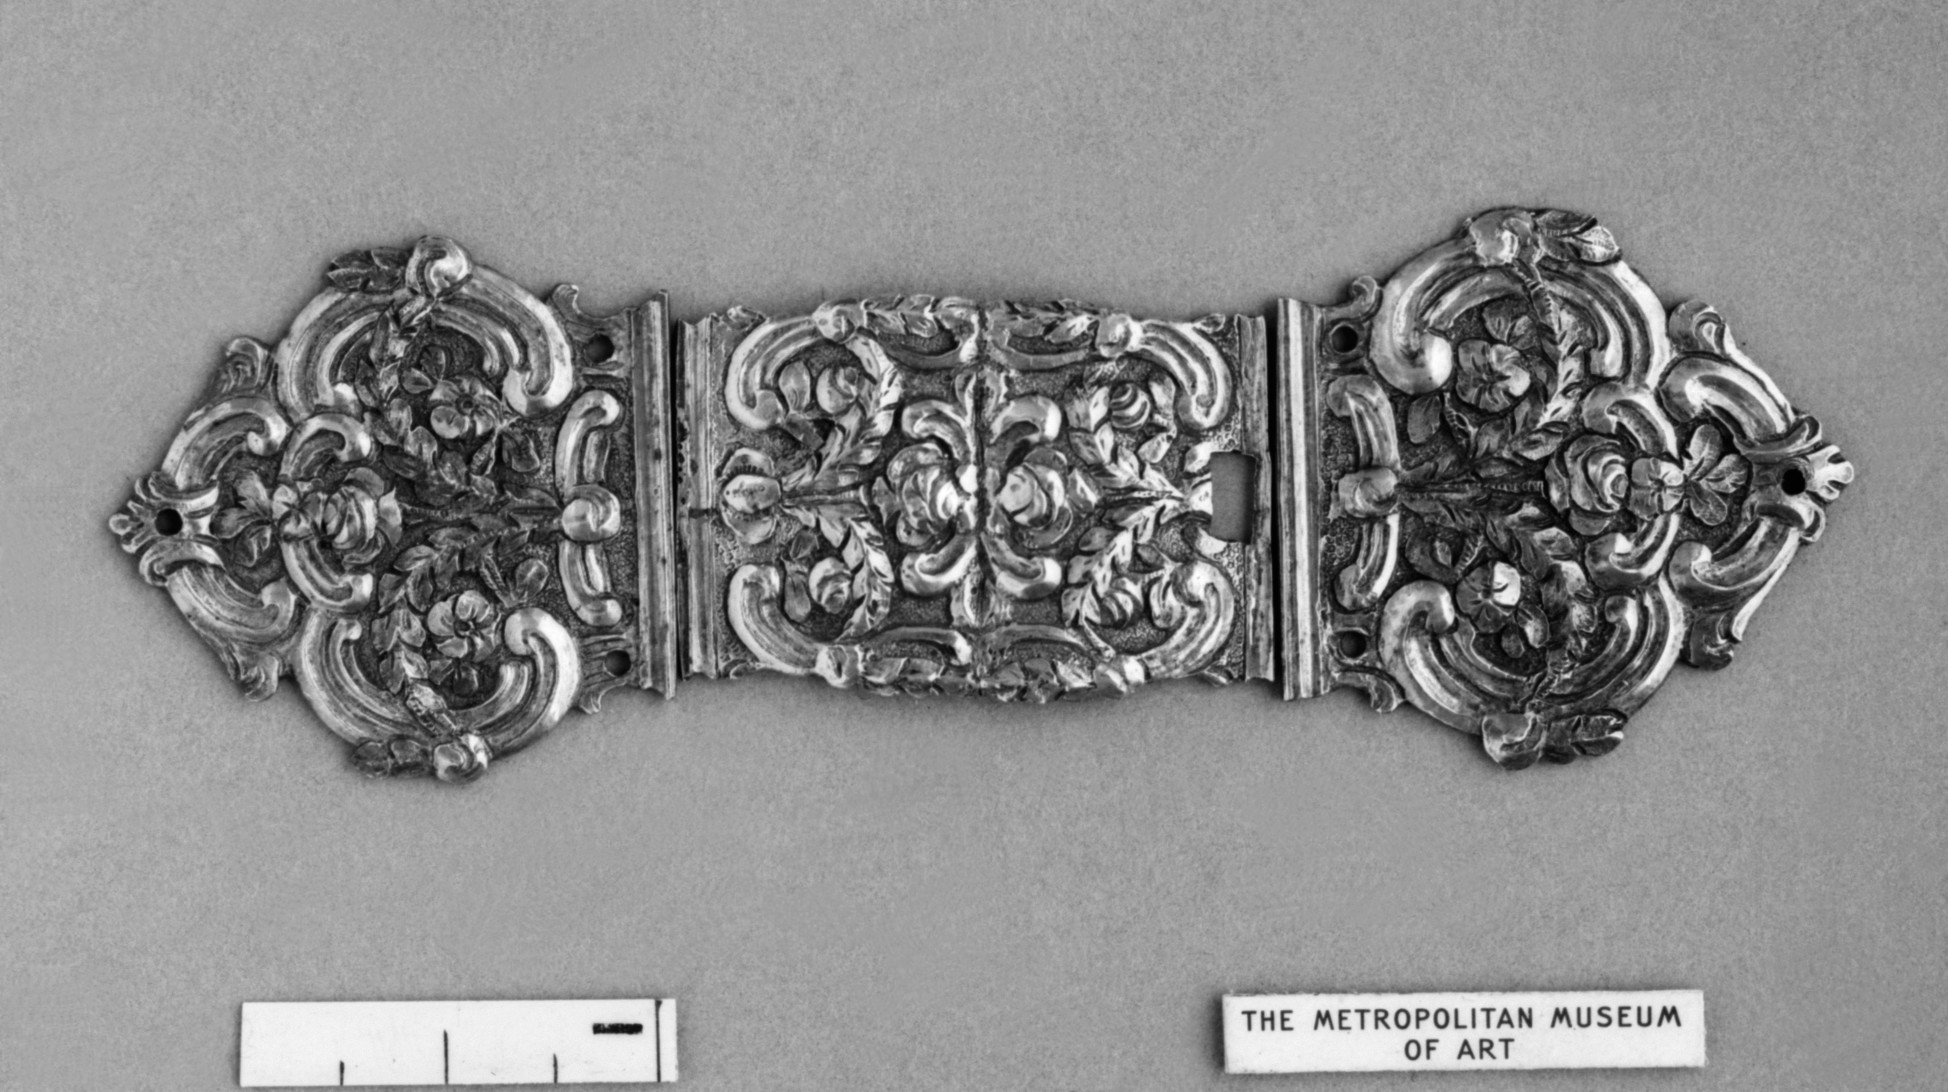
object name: book clasp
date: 1701-1800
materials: silver gilt